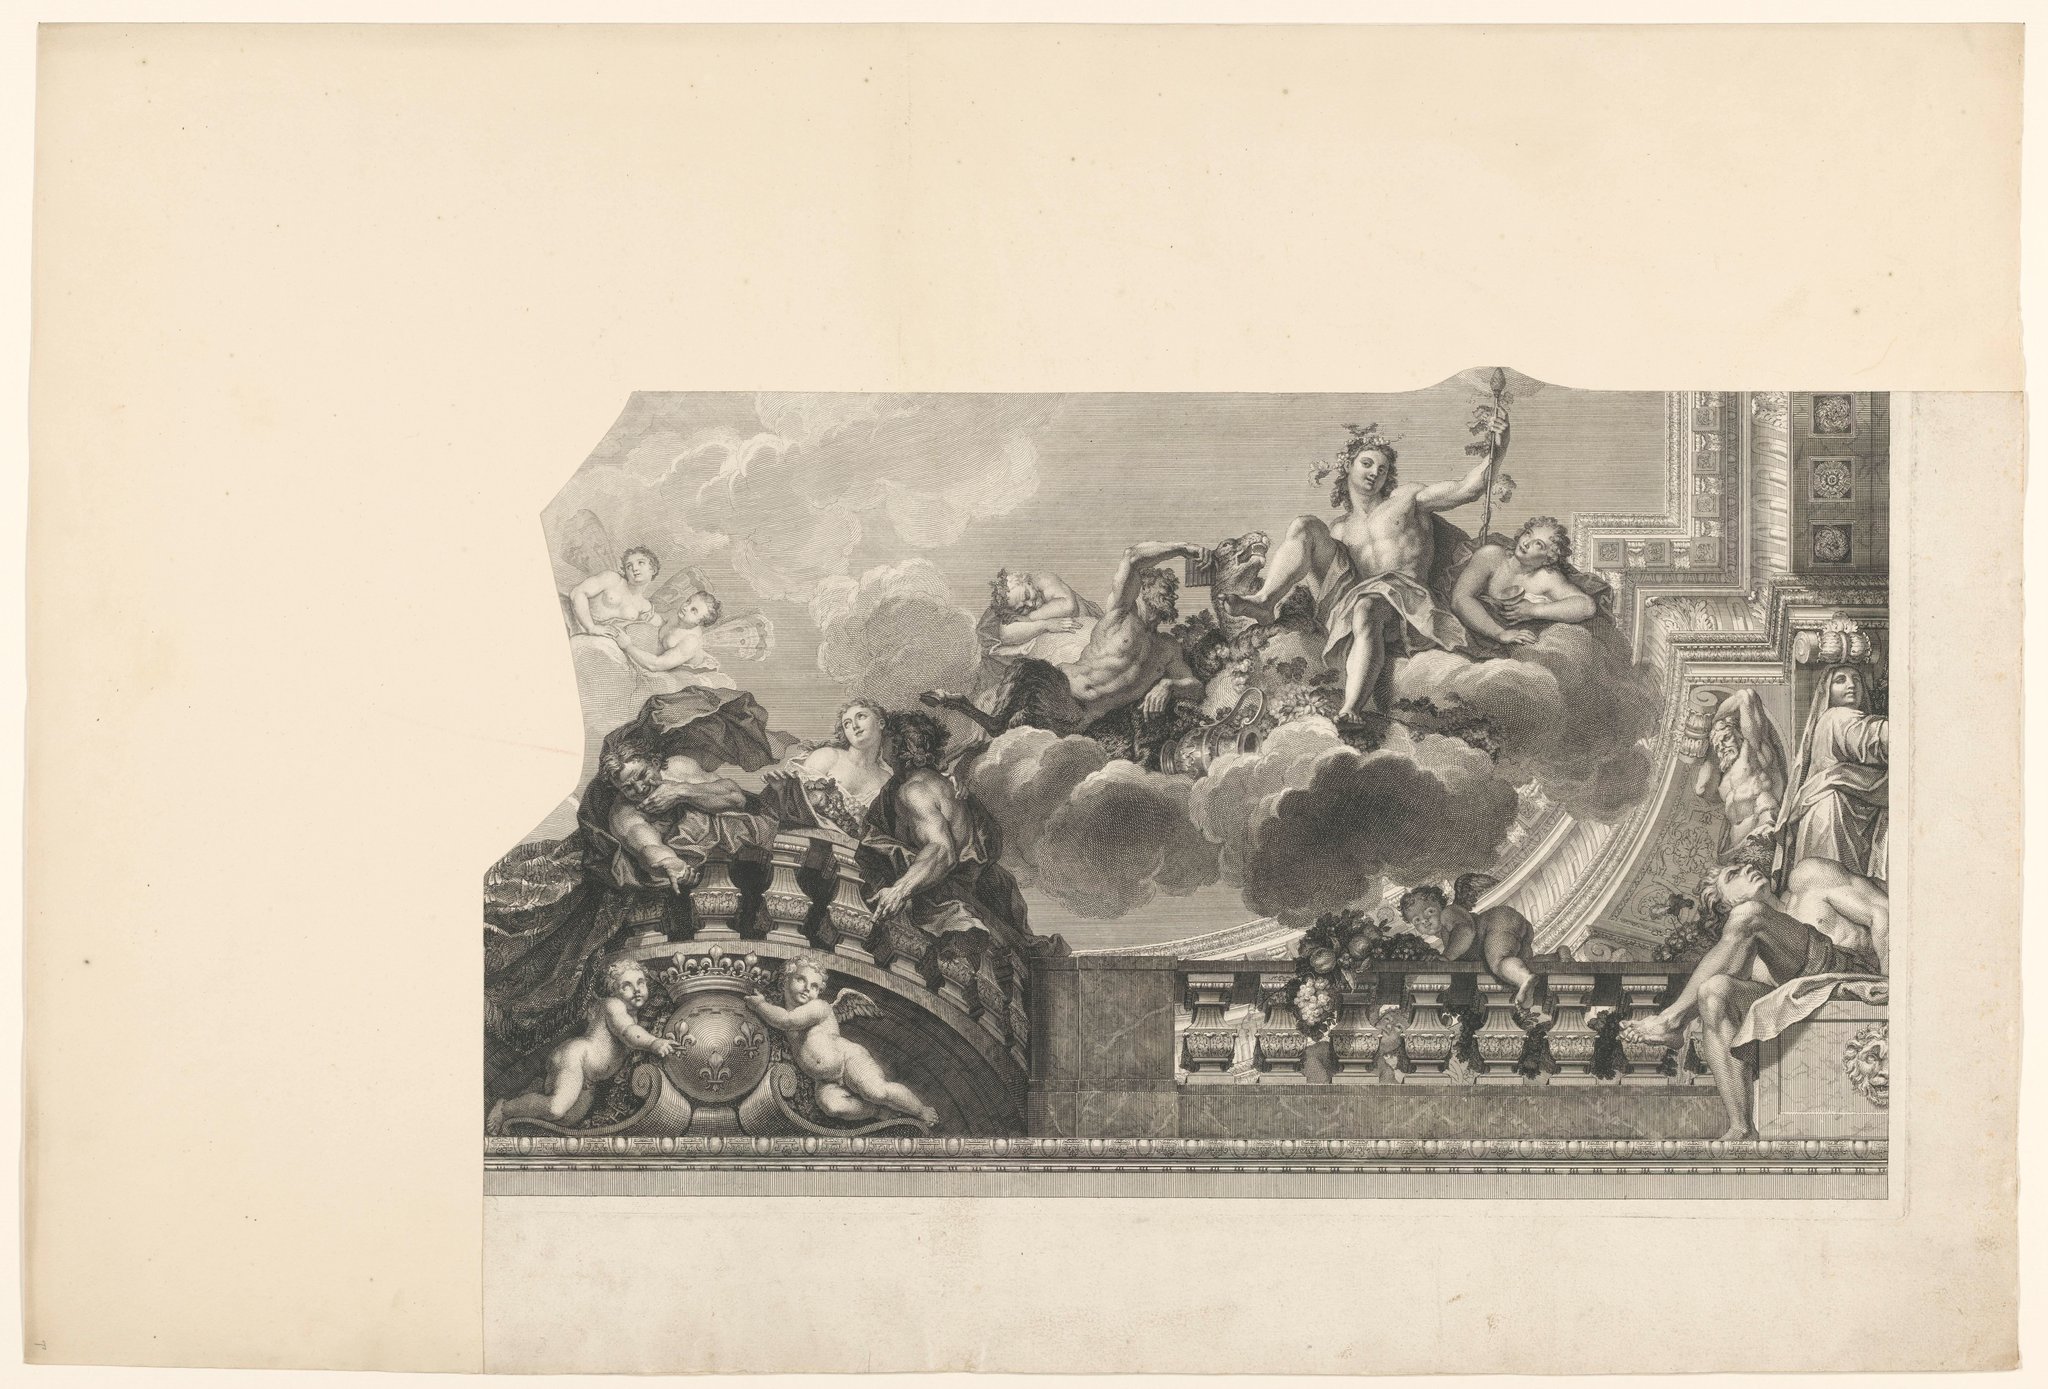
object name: print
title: Plafond du Milieu de la Grande Gallerie du Palais Royal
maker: nicolas henri tardieu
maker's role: print maker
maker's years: 1674-1749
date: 1717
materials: paper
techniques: engraving, etching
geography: france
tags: (story of) pan, roman deities, and foreign deities included in the classical pantheon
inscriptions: collector's mark: Lugt 240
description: Onderdeel van een prent gedrukt van vier platen.